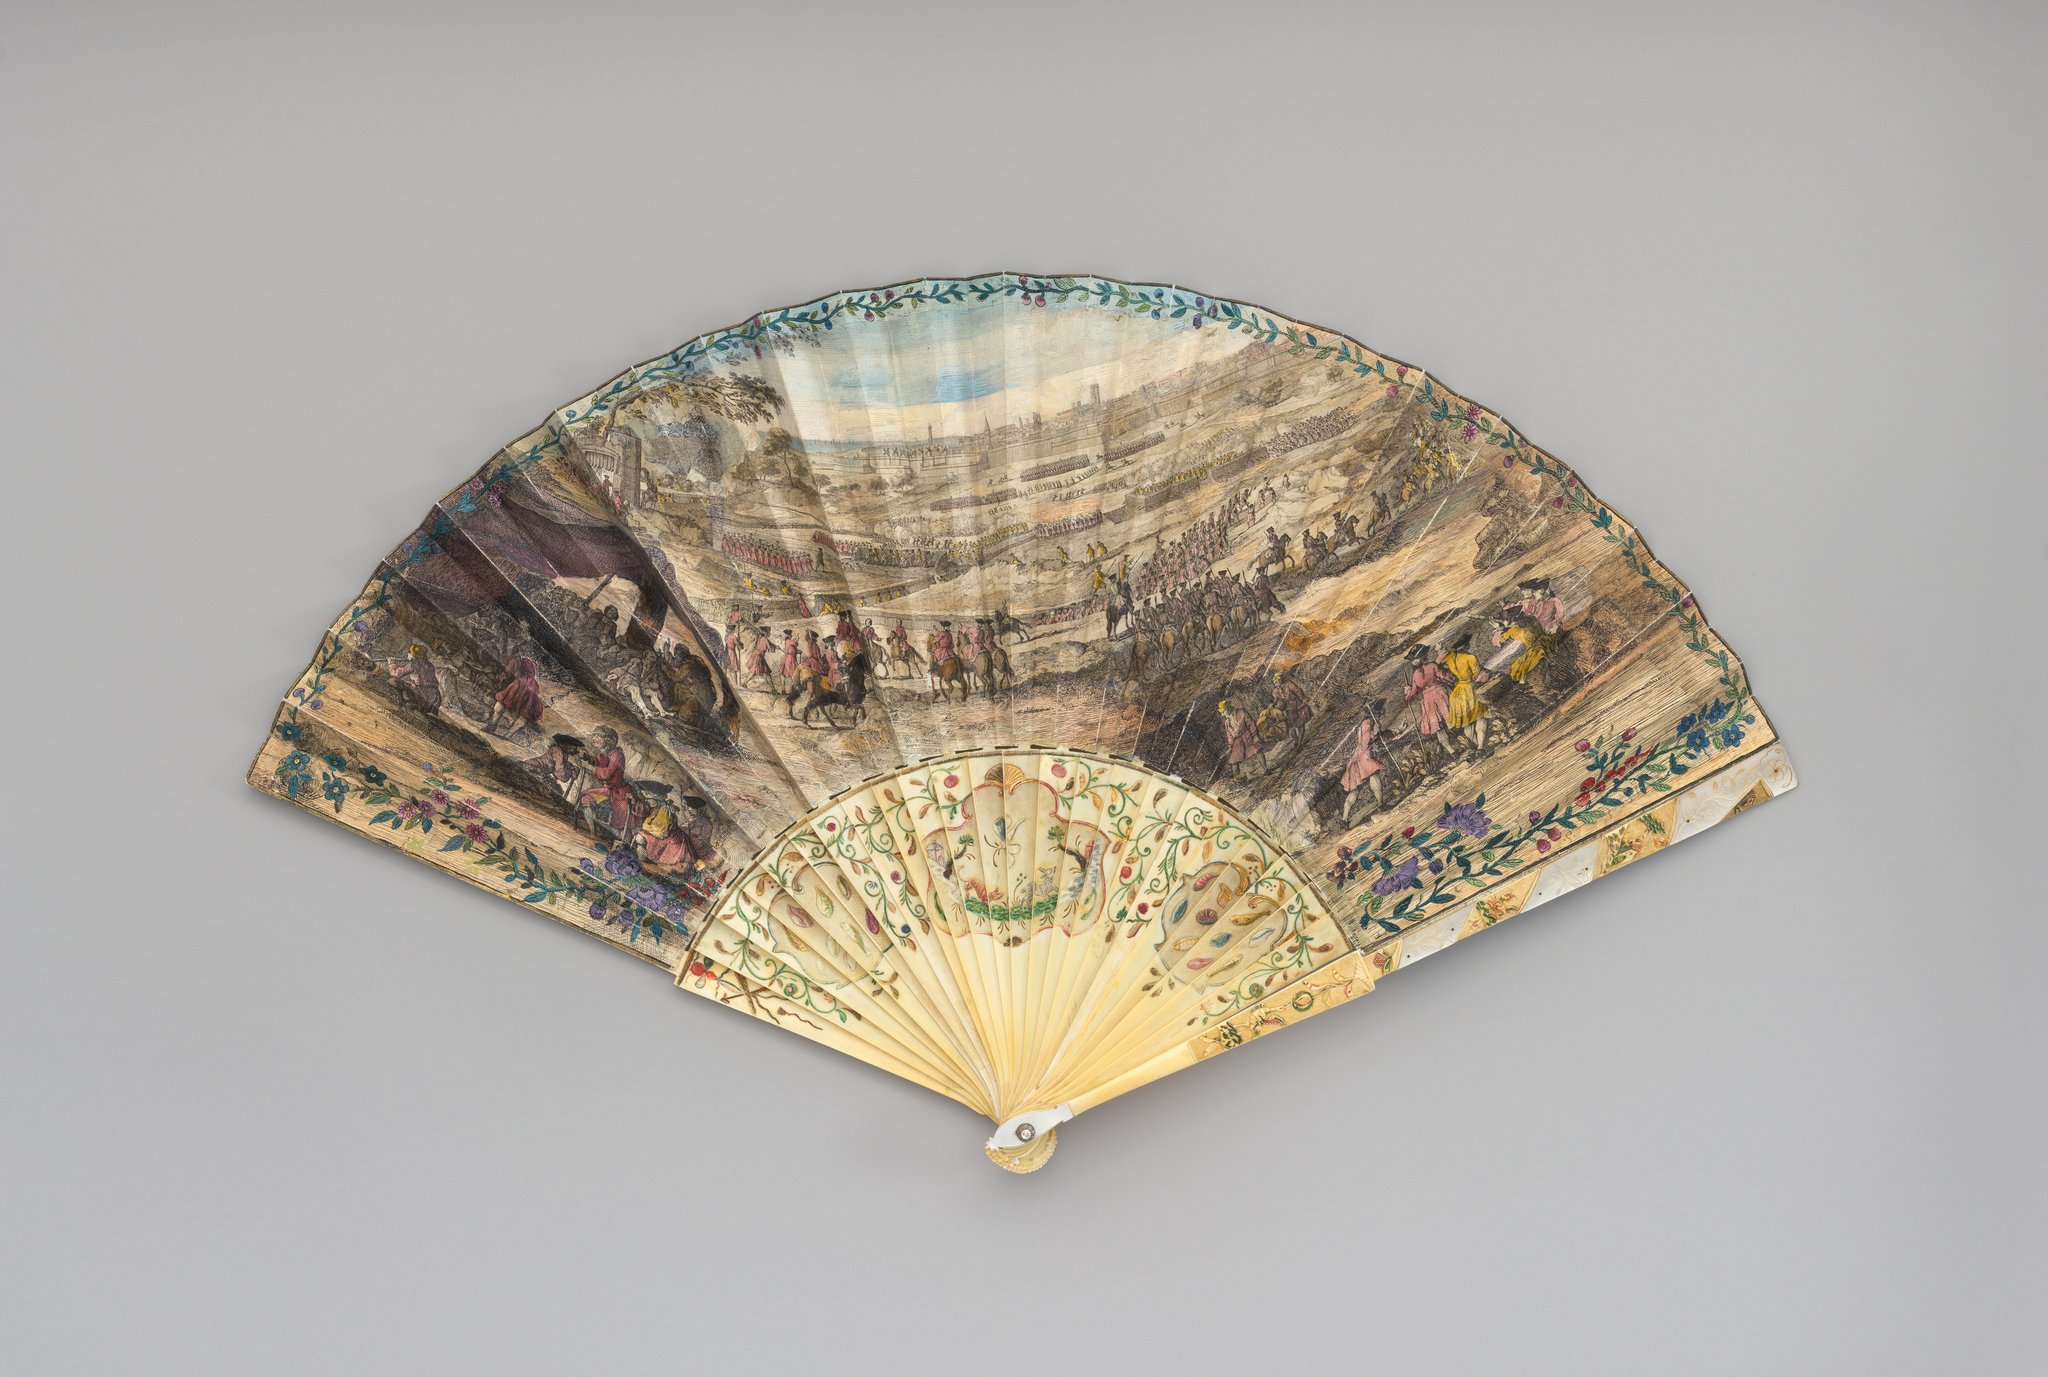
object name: fan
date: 1701-1800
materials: glass, ivory, parchment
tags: soldiers,horses,ships